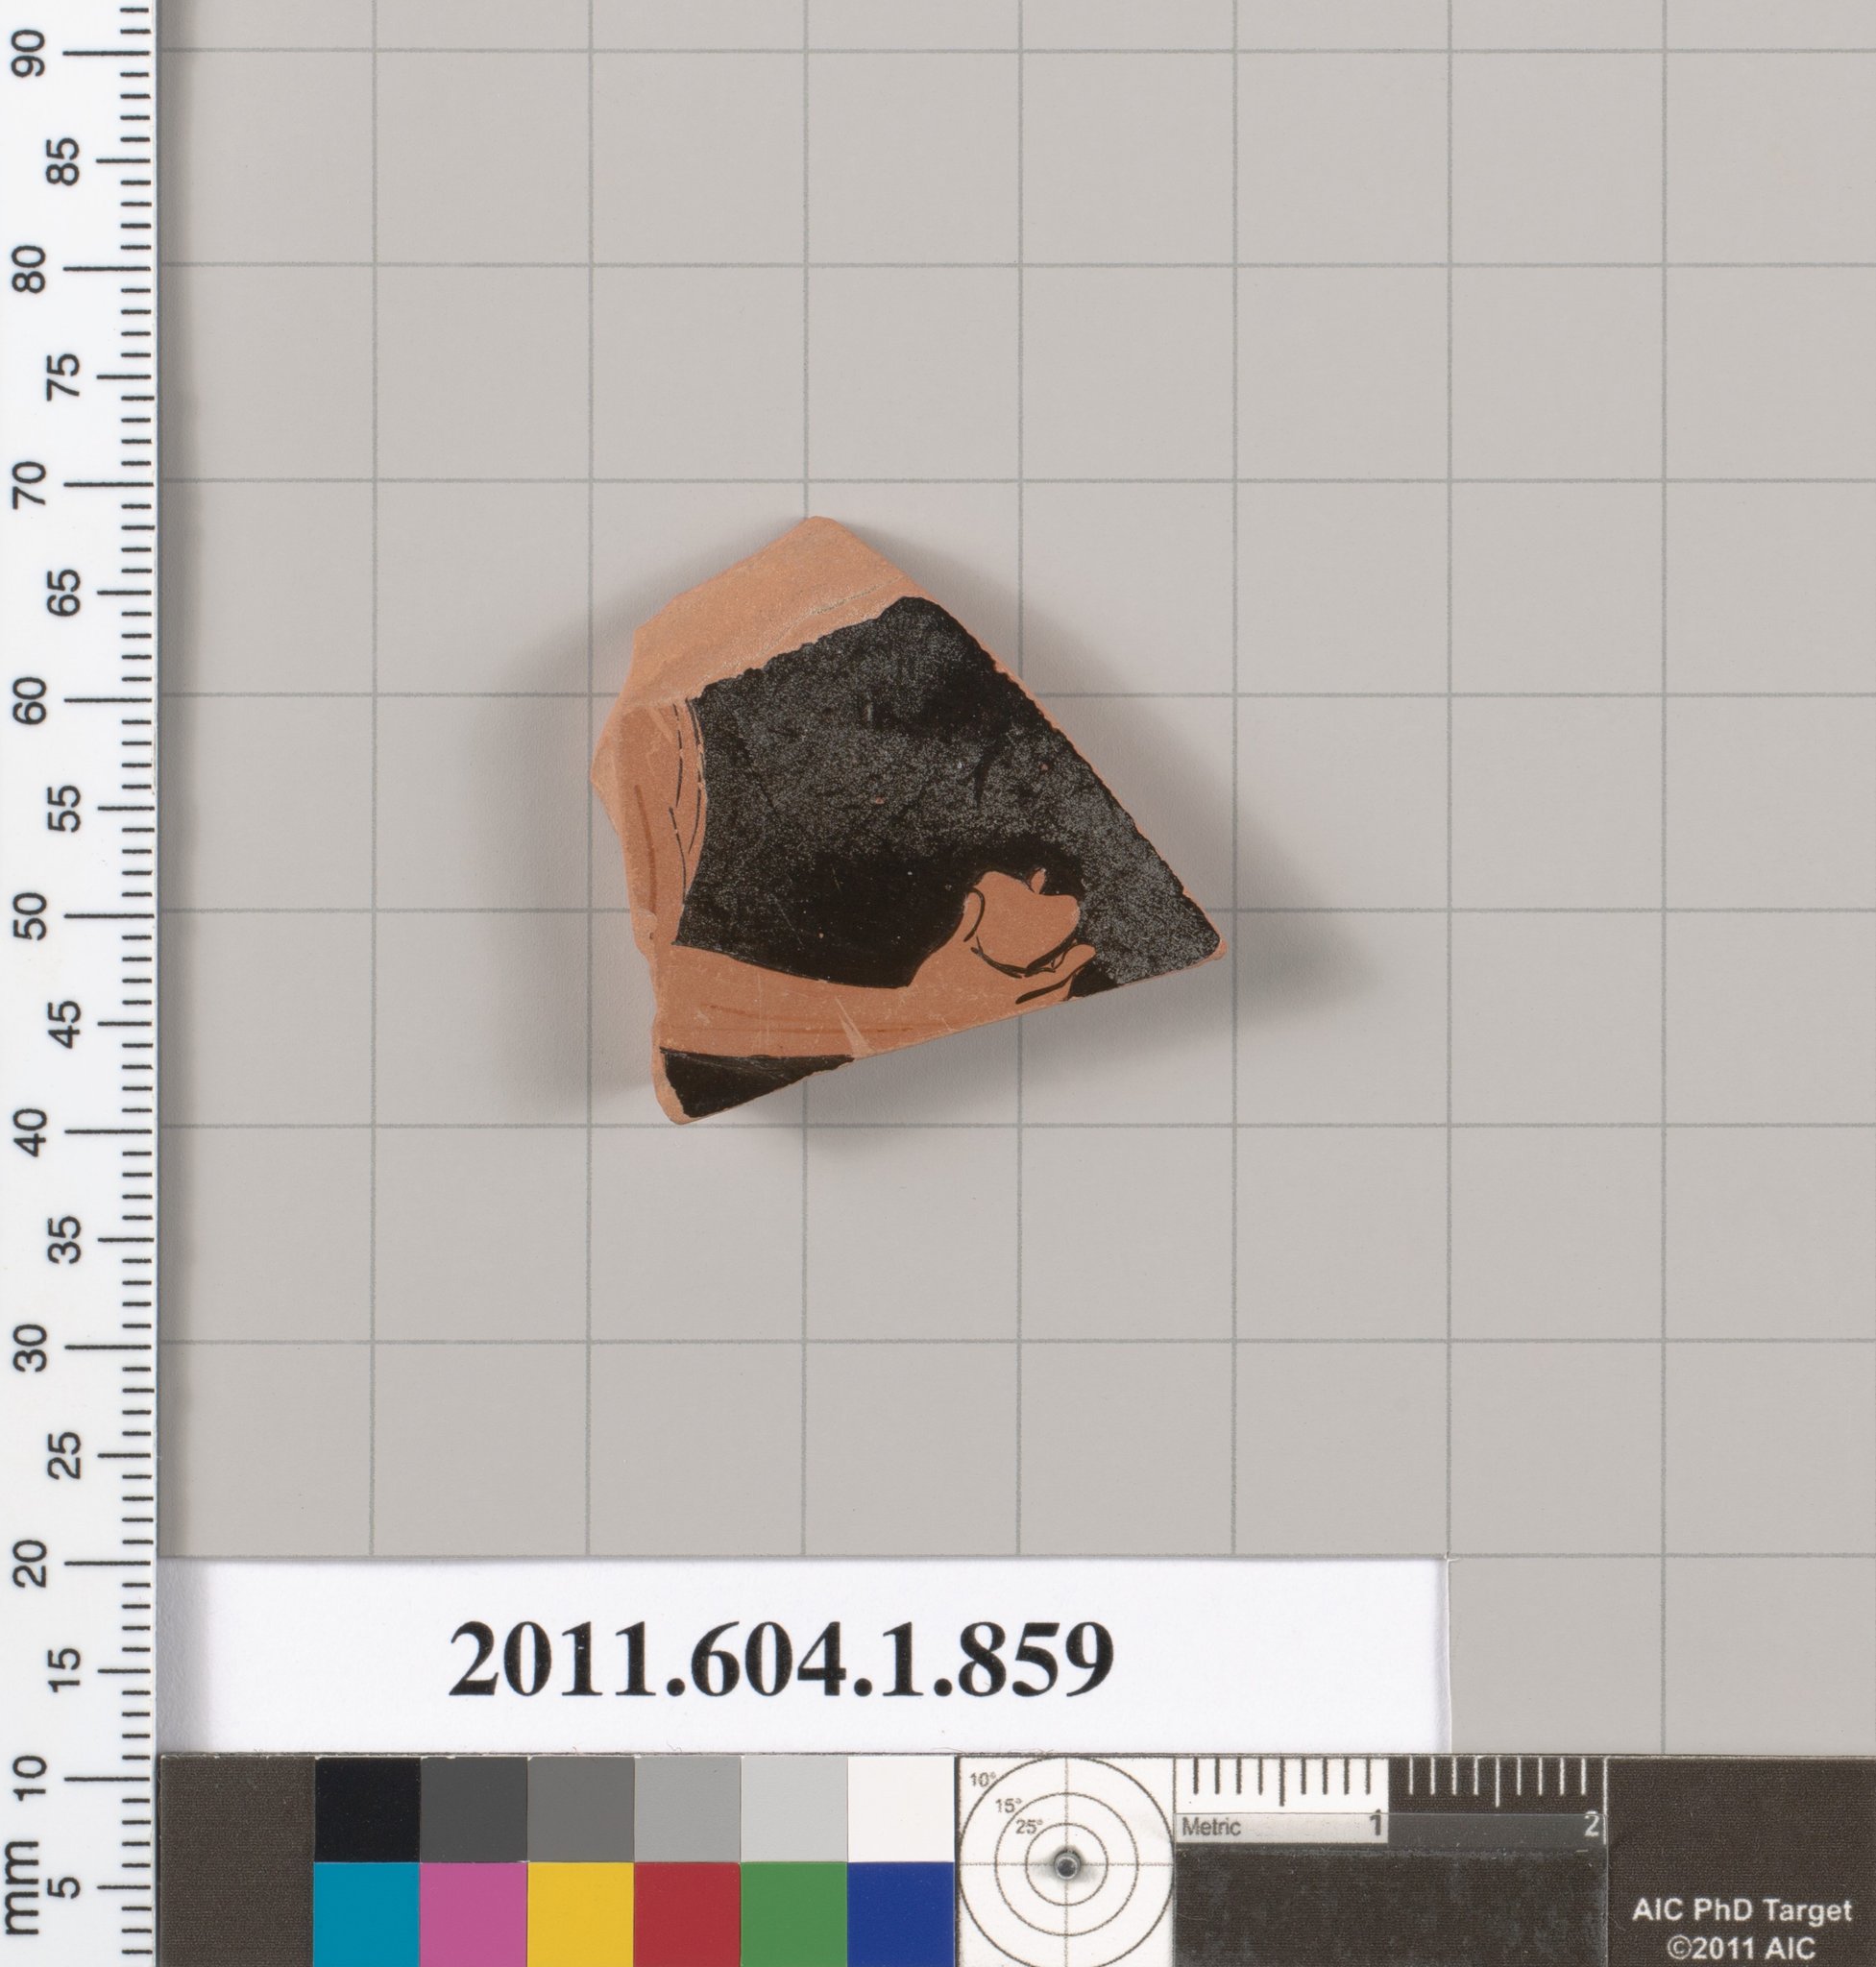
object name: kylix fragment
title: Terracotta fragment of a kylix (drinking cup)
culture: greek, attic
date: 460-450 BCE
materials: terracotta